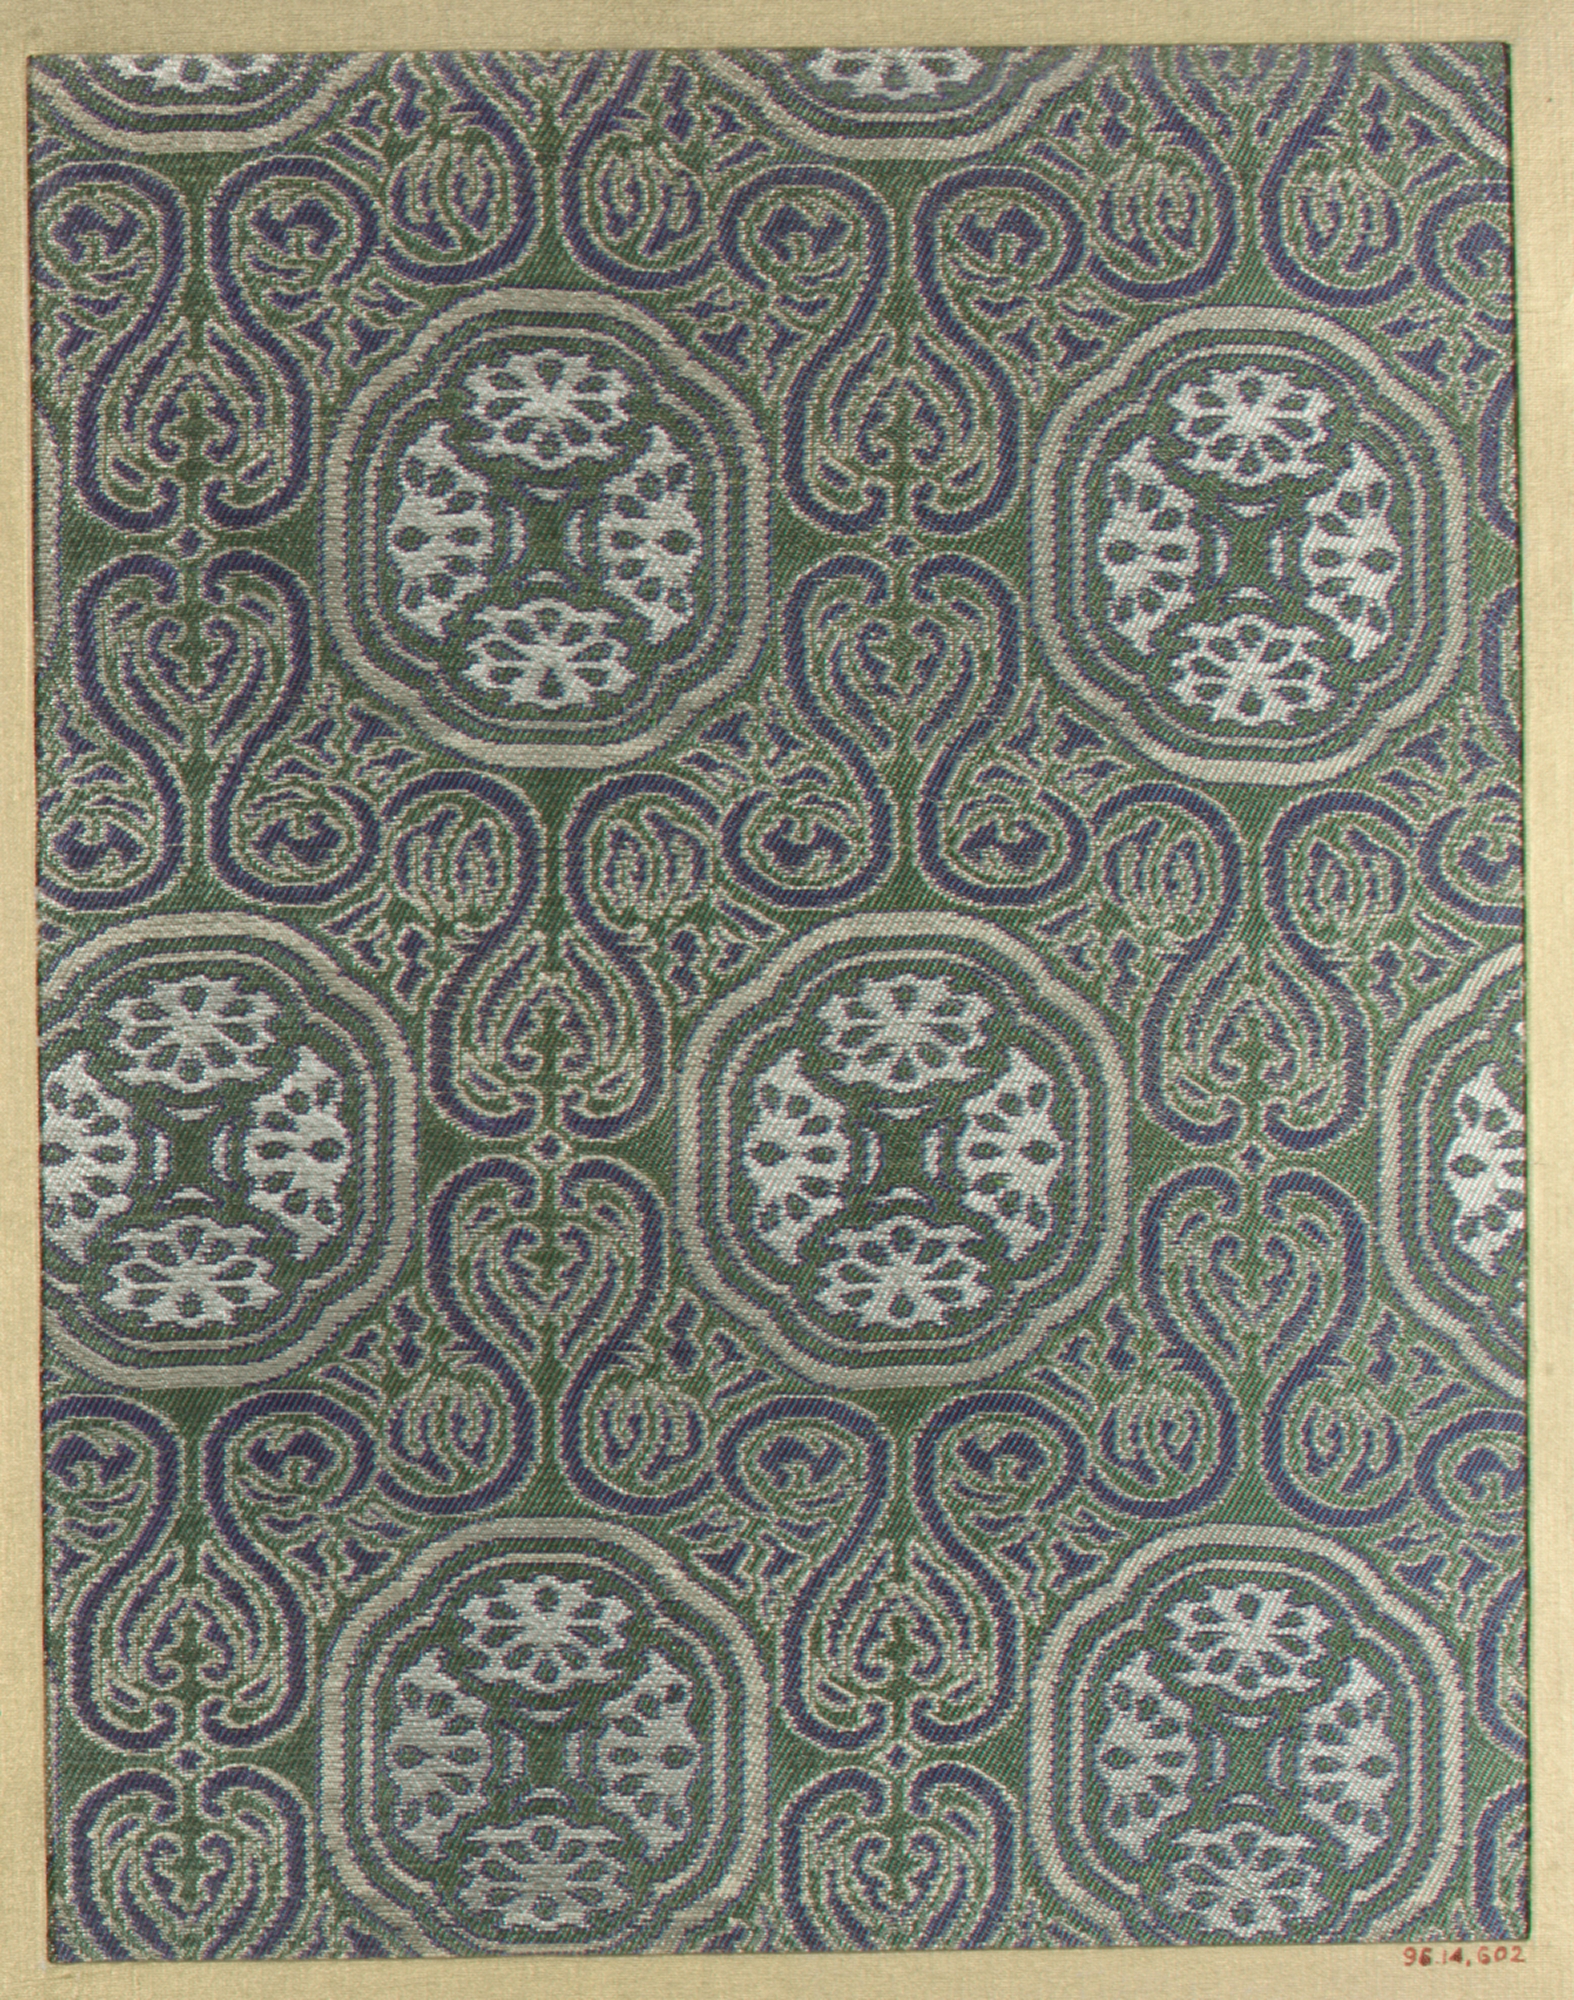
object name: piece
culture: japanese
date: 1701-1900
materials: silk